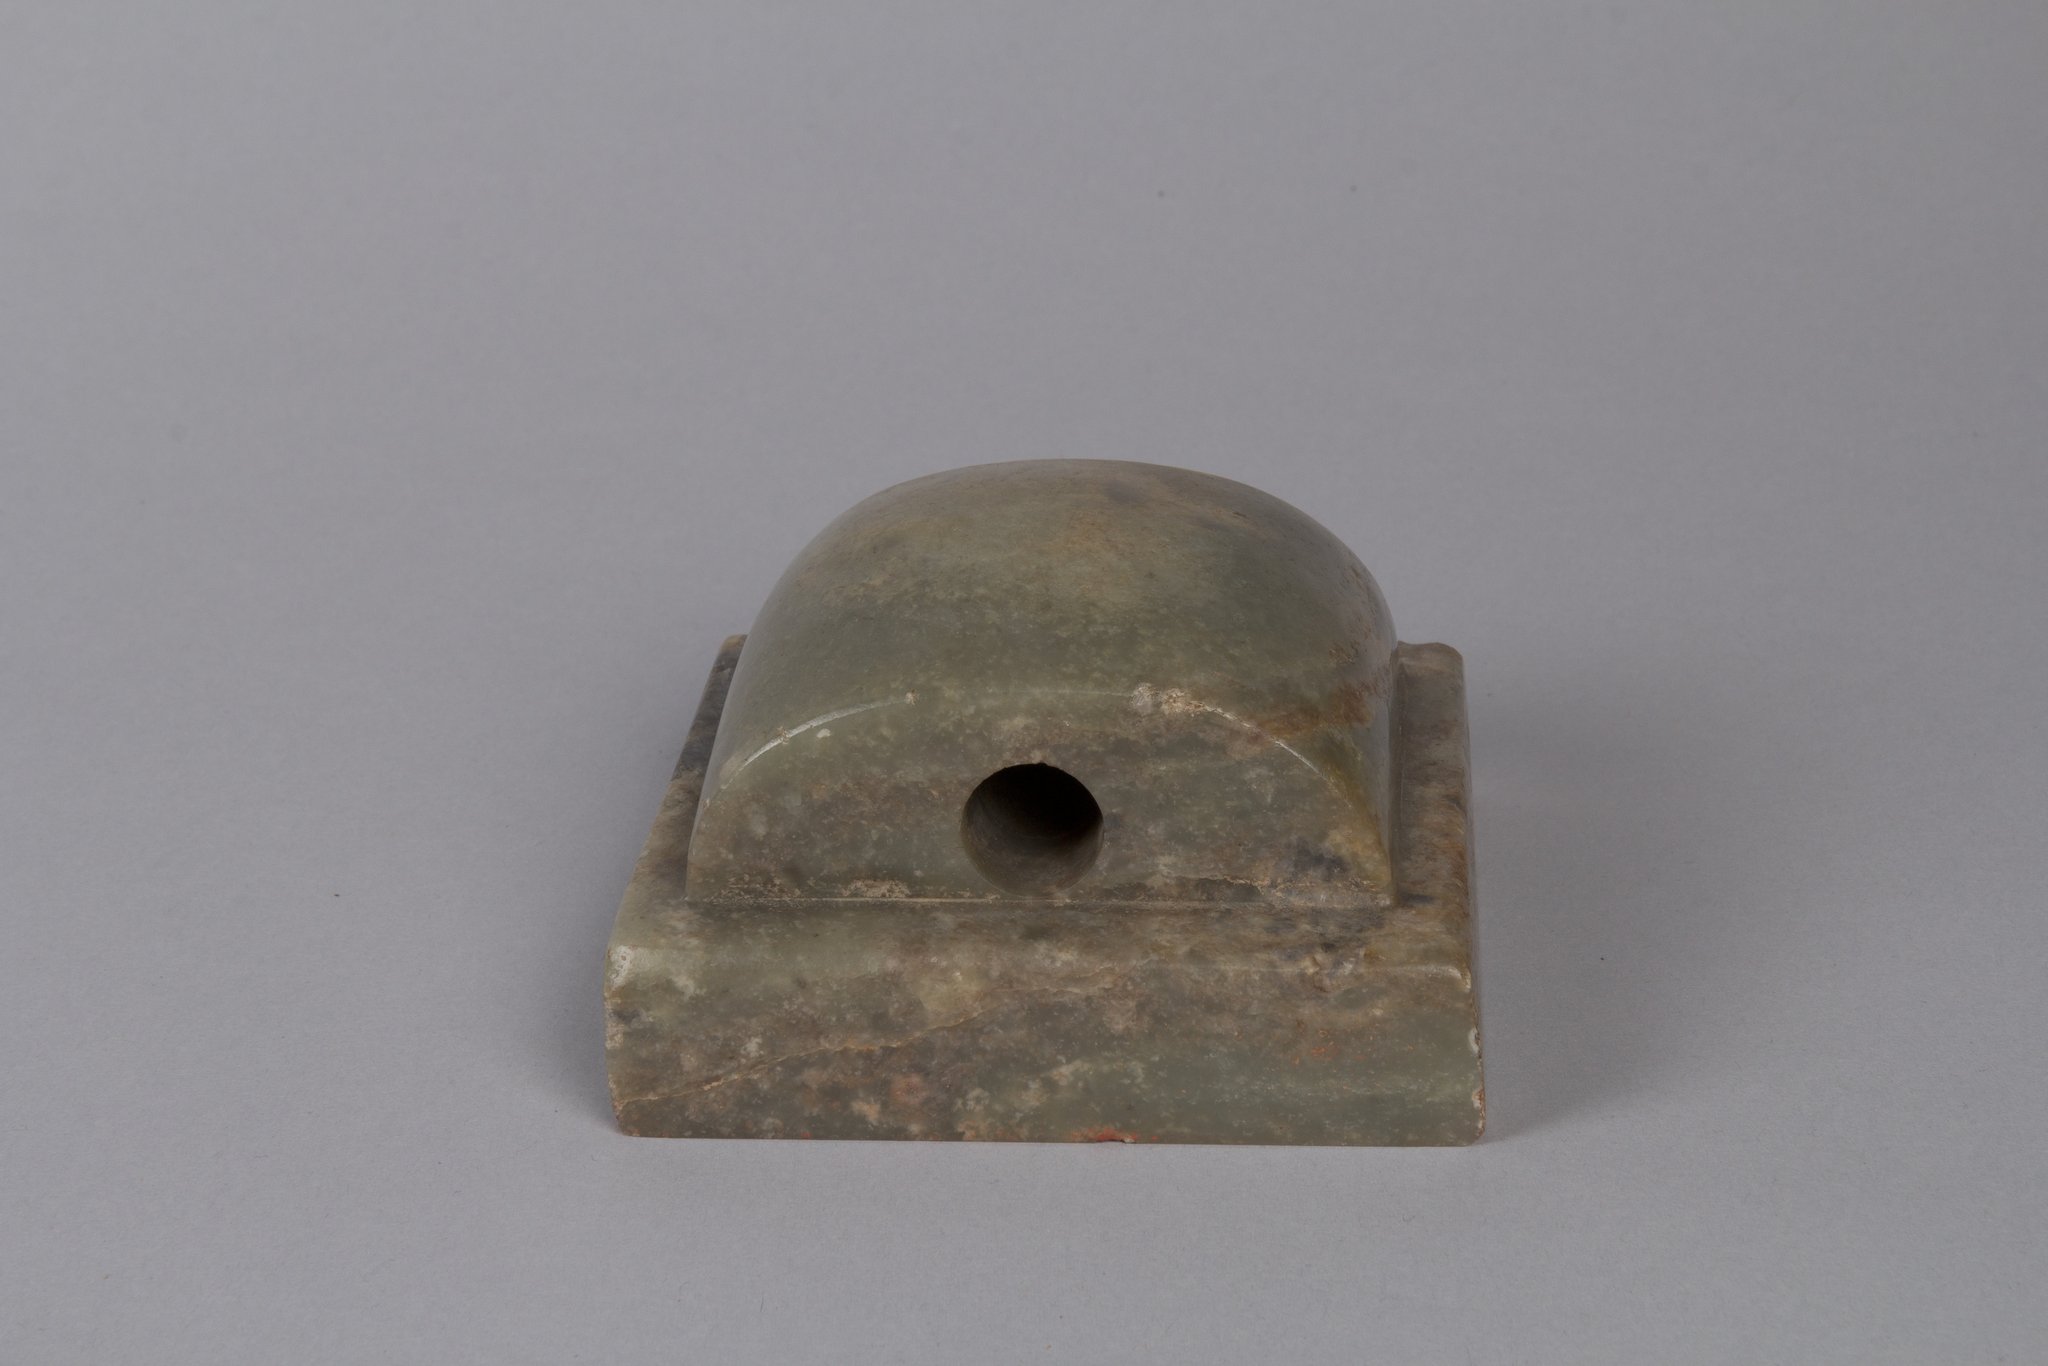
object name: seal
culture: chinese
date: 1901-1933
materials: jade